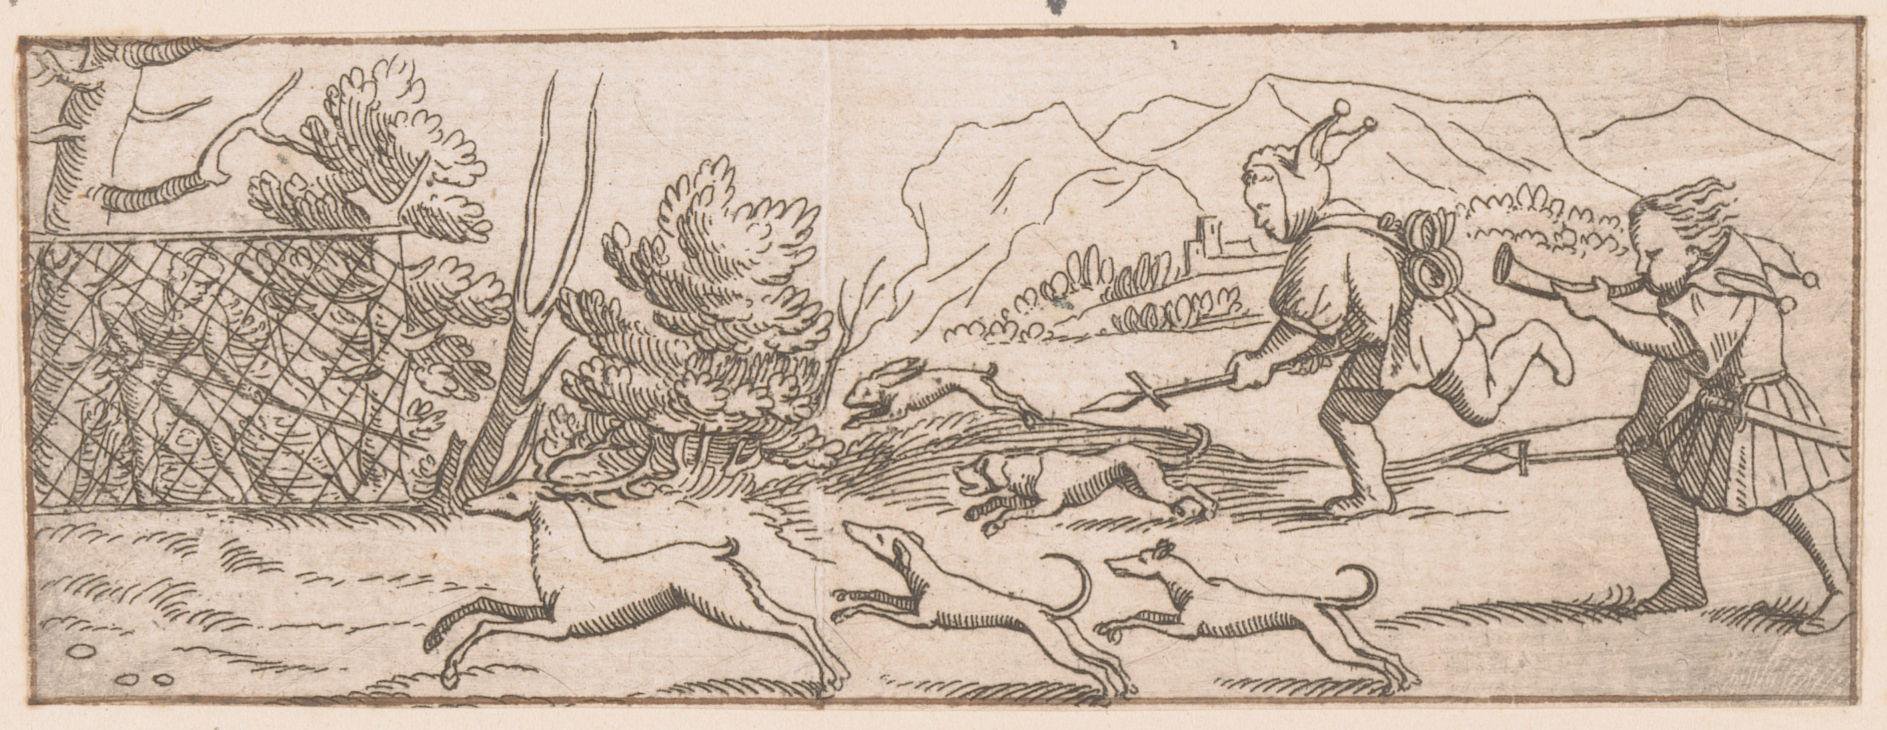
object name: book illustration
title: Twee narren op jacht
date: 1516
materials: paper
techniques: etching, letterpress printing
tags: desiderius erasmus, court jester, court fool, folly, foolishness; 'pazzia', 'sciocchezza', 'stoltitia' (ripa), roe-hunting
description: Prent afkomstig uit: Erasmus, Desiderius. Morias enkomion (...). Bazel: Johann Rudolf Genath, 1676. De prenten hierin zijn naar tekeningen die Hans en Ambrosius Holbein maakten voor de theoloog Oswald Myconius in diens uitgave van de Moriae encomium (Lof der Zotheid) van 1516.